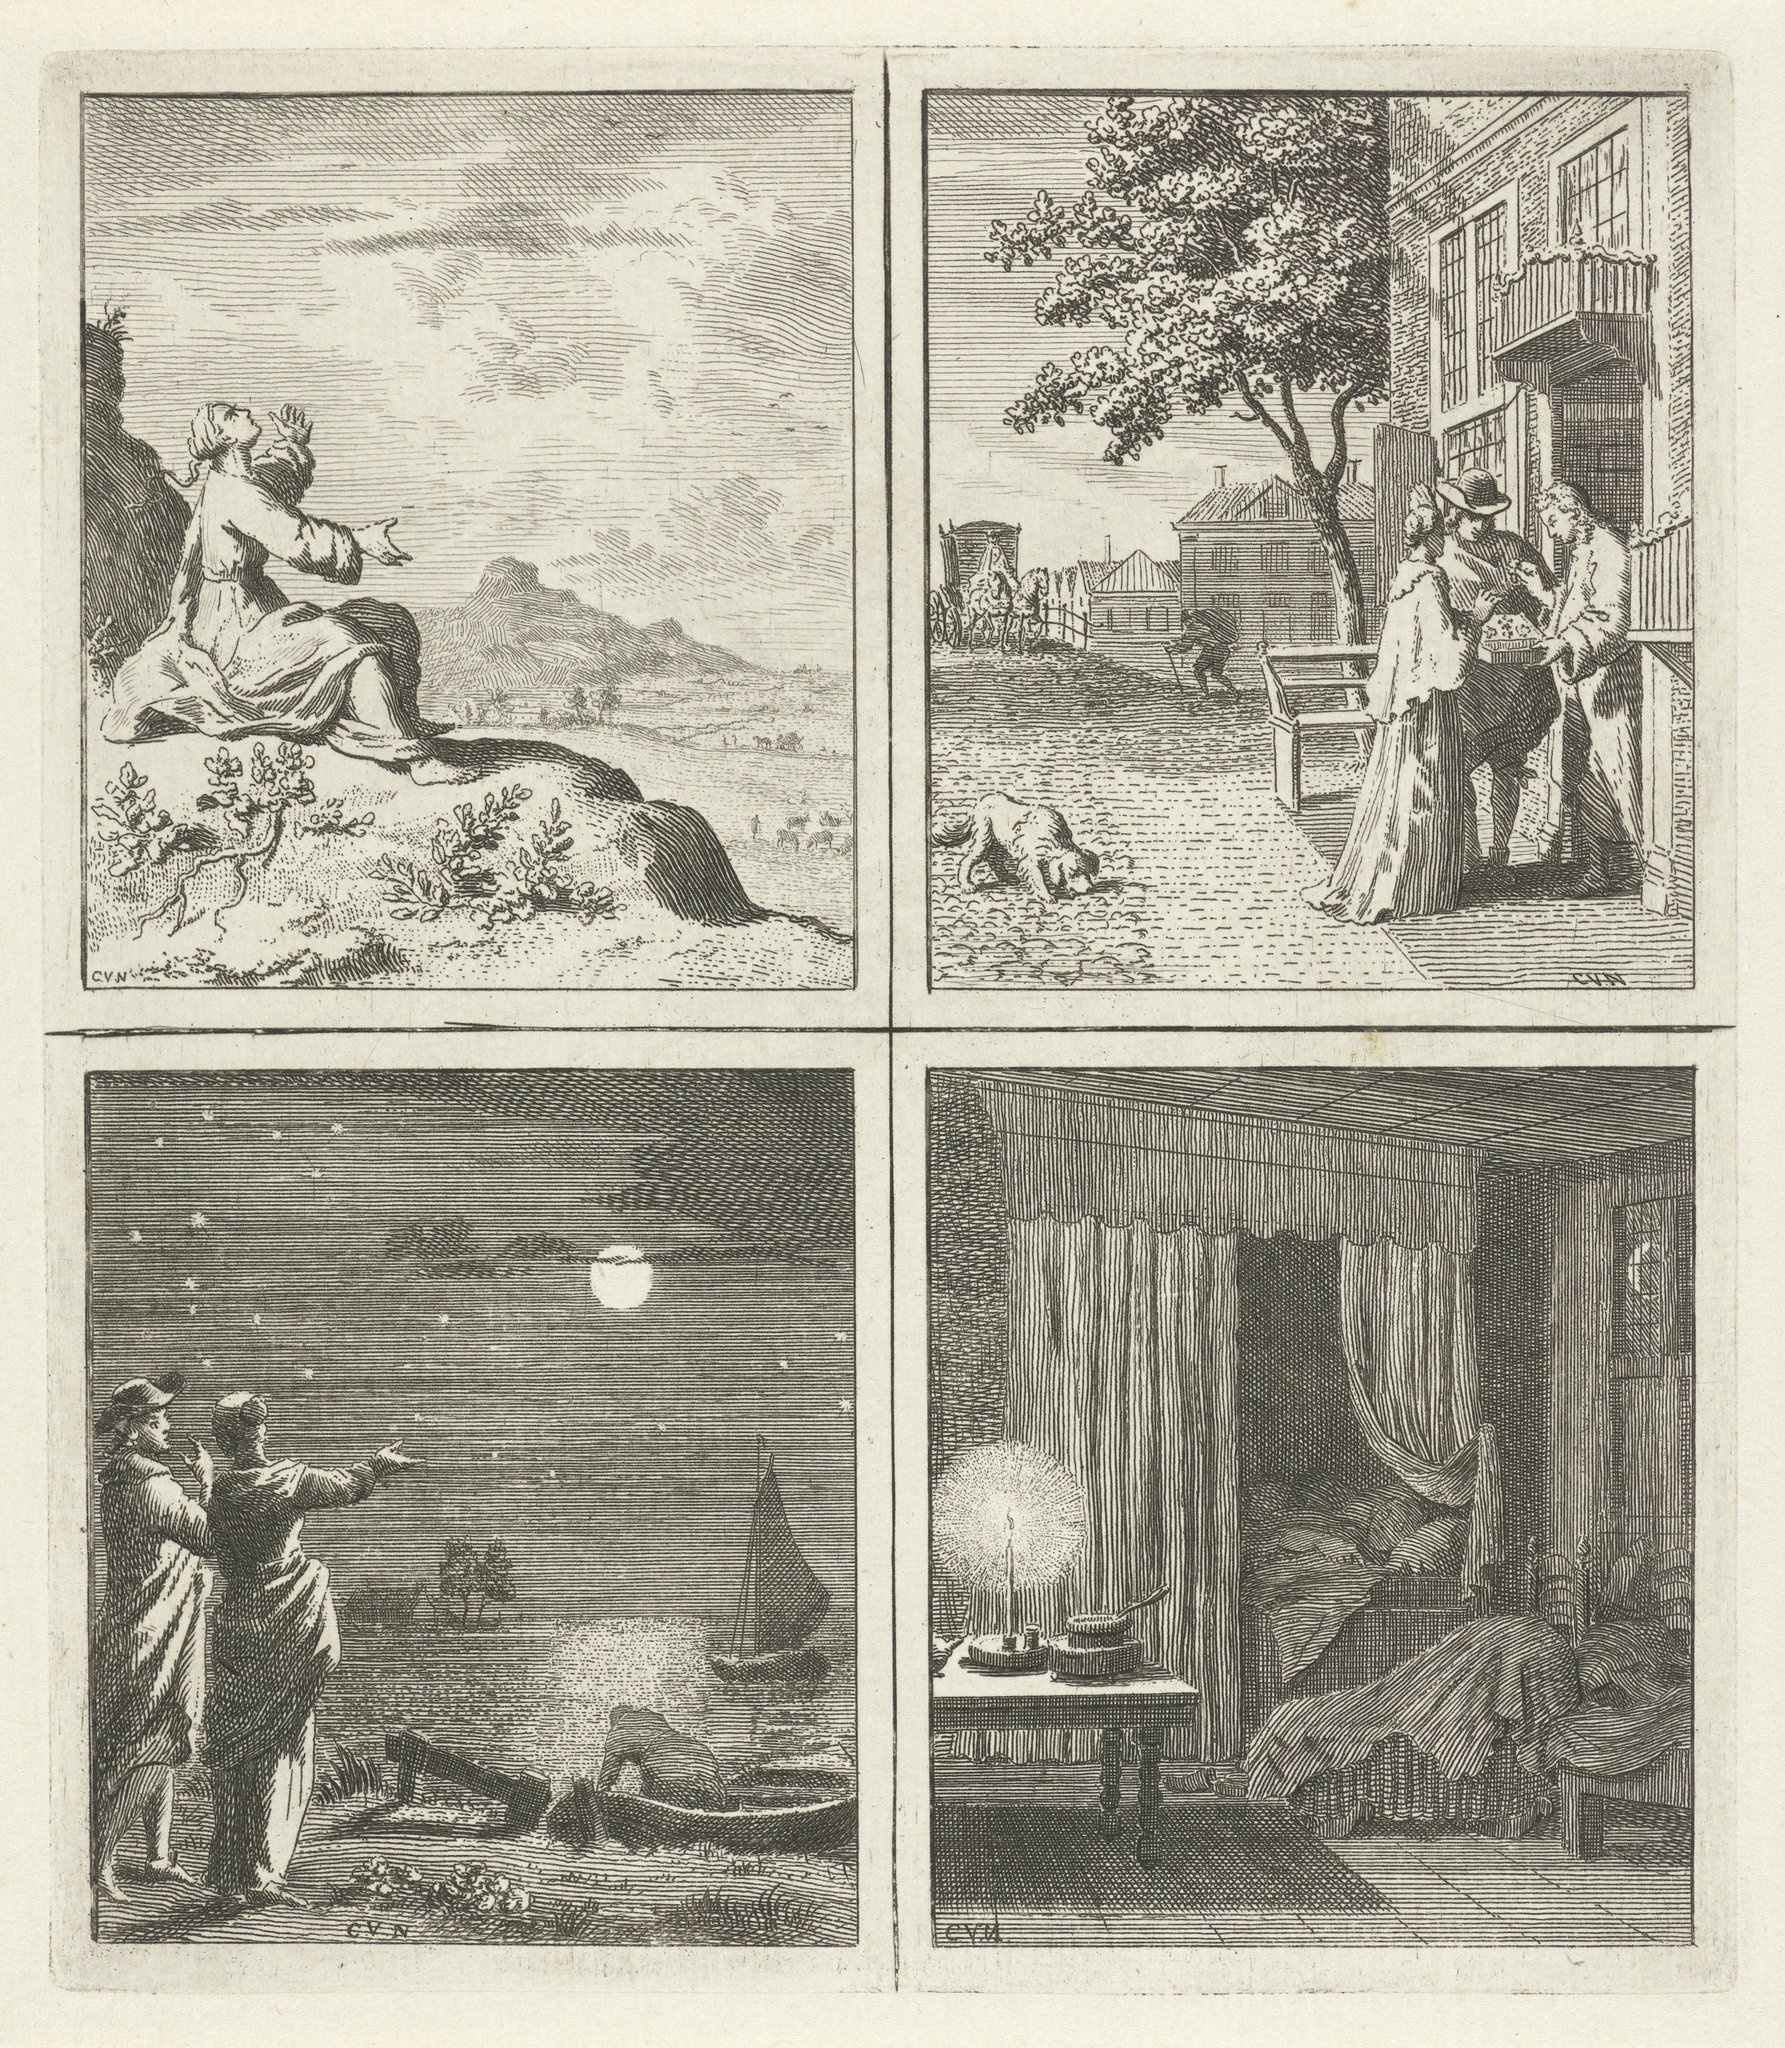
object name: print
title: De Hemel / Juwelen / Maan en sterren / Nachtrust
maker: cornelis van noorde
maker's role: draughtsman, print maker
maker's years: 1731-1795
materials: paper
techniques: etching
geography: haarlem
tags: contemplating the firmament, sleeping in bed, candle, jewel-box, moon as celestial body, dog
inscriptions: collector's mark: Lugt 240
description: Vier voorstellingen. Linksboven: een vrouw in een landschap, terwijl zij in verwondering haar handen opheft en naar de hemel kijkt. Rechtsboven: twee mannen en een vrouw voor de deur van een juwelier, terwijl zij in een juwelenkist kijken naar diamanten. Op straat een hond en op de brug een koets. Linksonder: een man en een vrouw kijken over het water naar de maan en de sterren. Op het water een zeilschip. Rechtsonder: een slaapkamer met op tafel een brandende kaars. In bed ligt iemand te slapen.